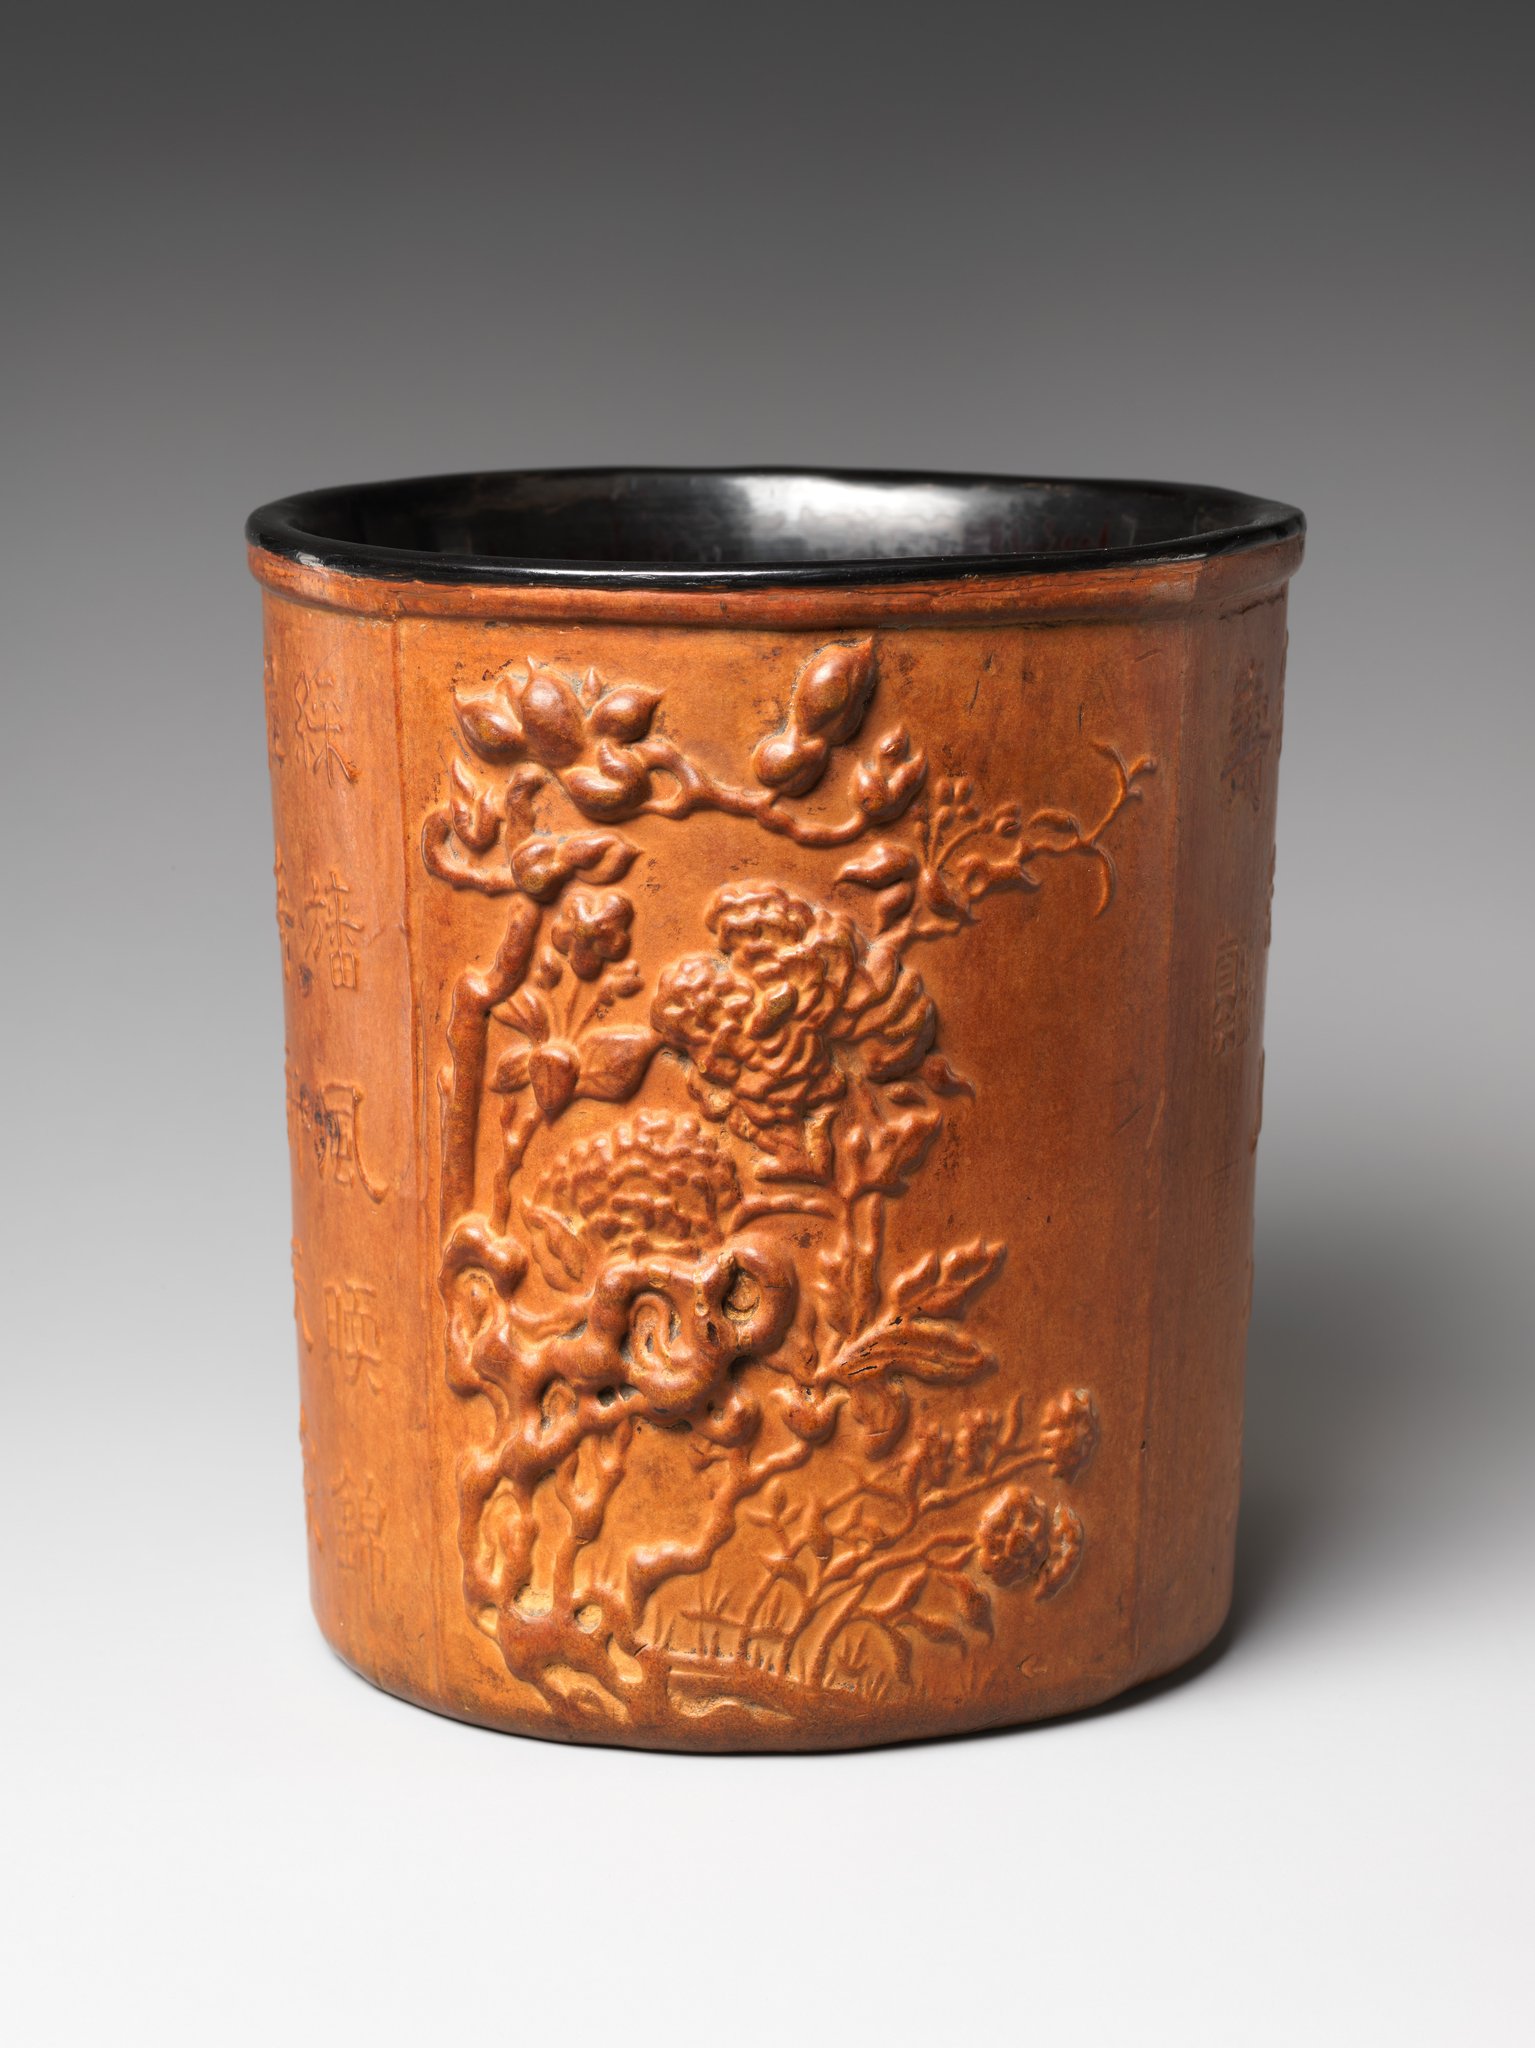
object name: brush holder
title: Brush holder with flowers and poems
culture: chinese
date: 1801-1900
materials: lacquer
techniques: molding